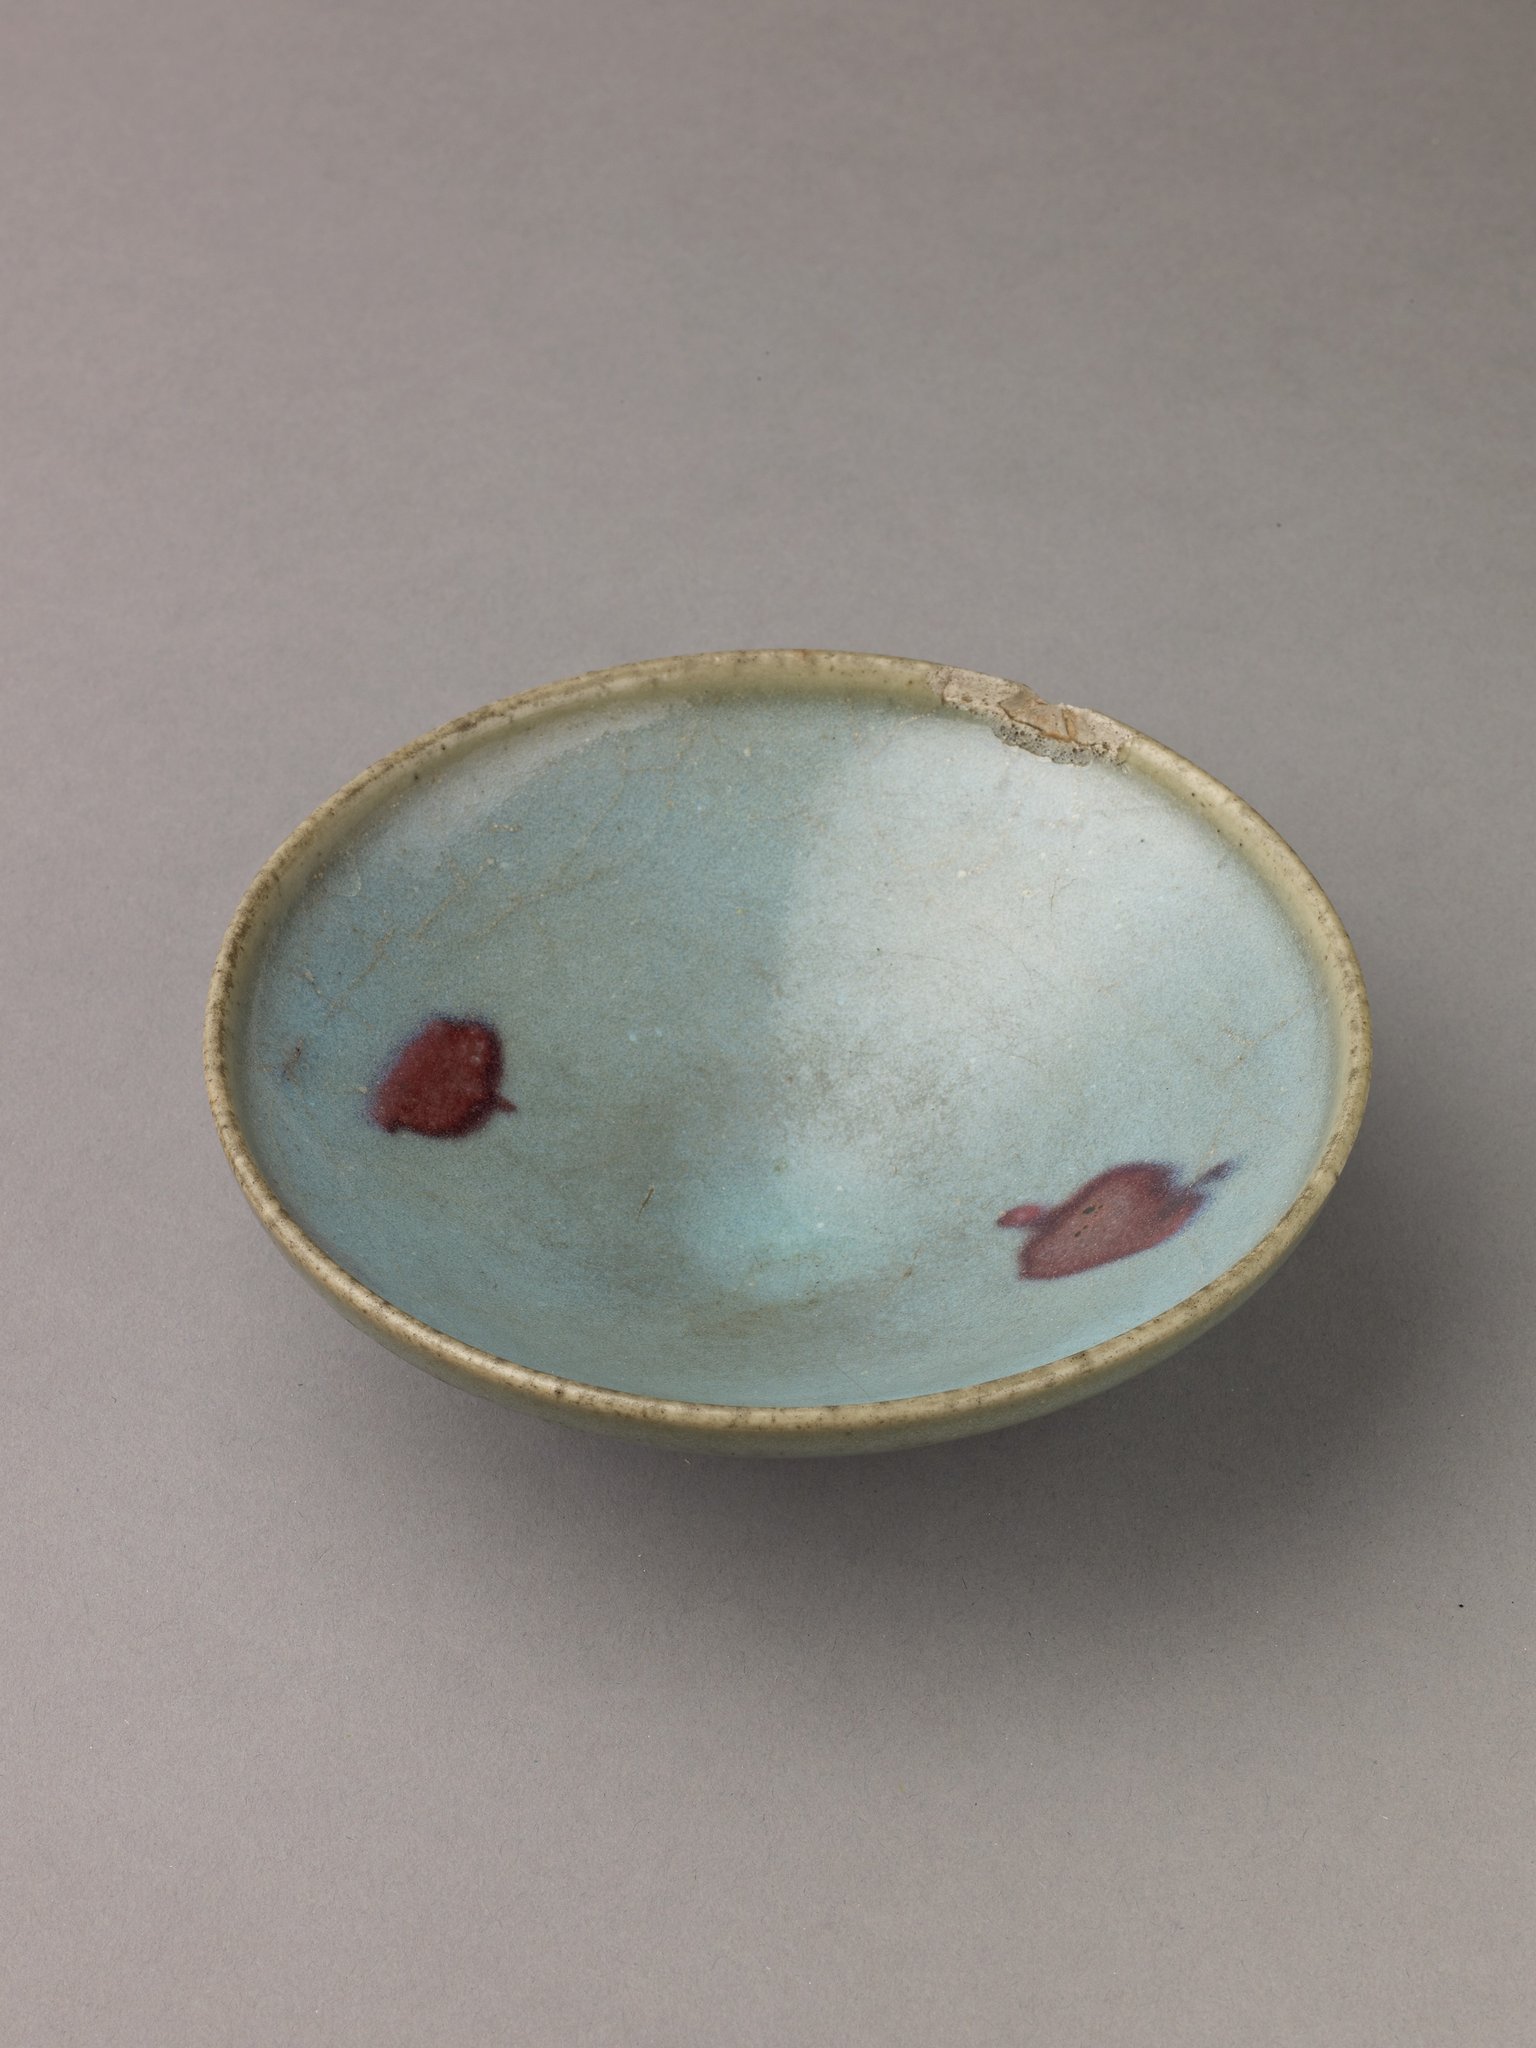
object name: bowl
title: Deep bowl, Jun ware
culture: chinese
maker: chinese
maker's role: artist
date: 1201-1300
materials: glaze, stoneware